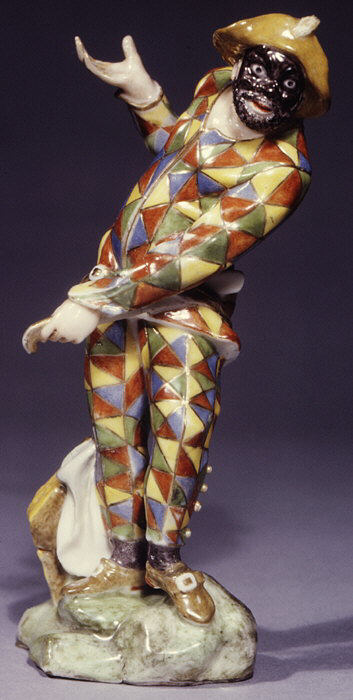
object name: figure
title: Harlequin (one of a pair)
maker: capodimonte porcelain manufactory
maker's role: manufactory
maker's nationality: italian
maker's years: 1740-1759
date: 1750-1752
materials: soft paste porcelain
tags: men,clowns